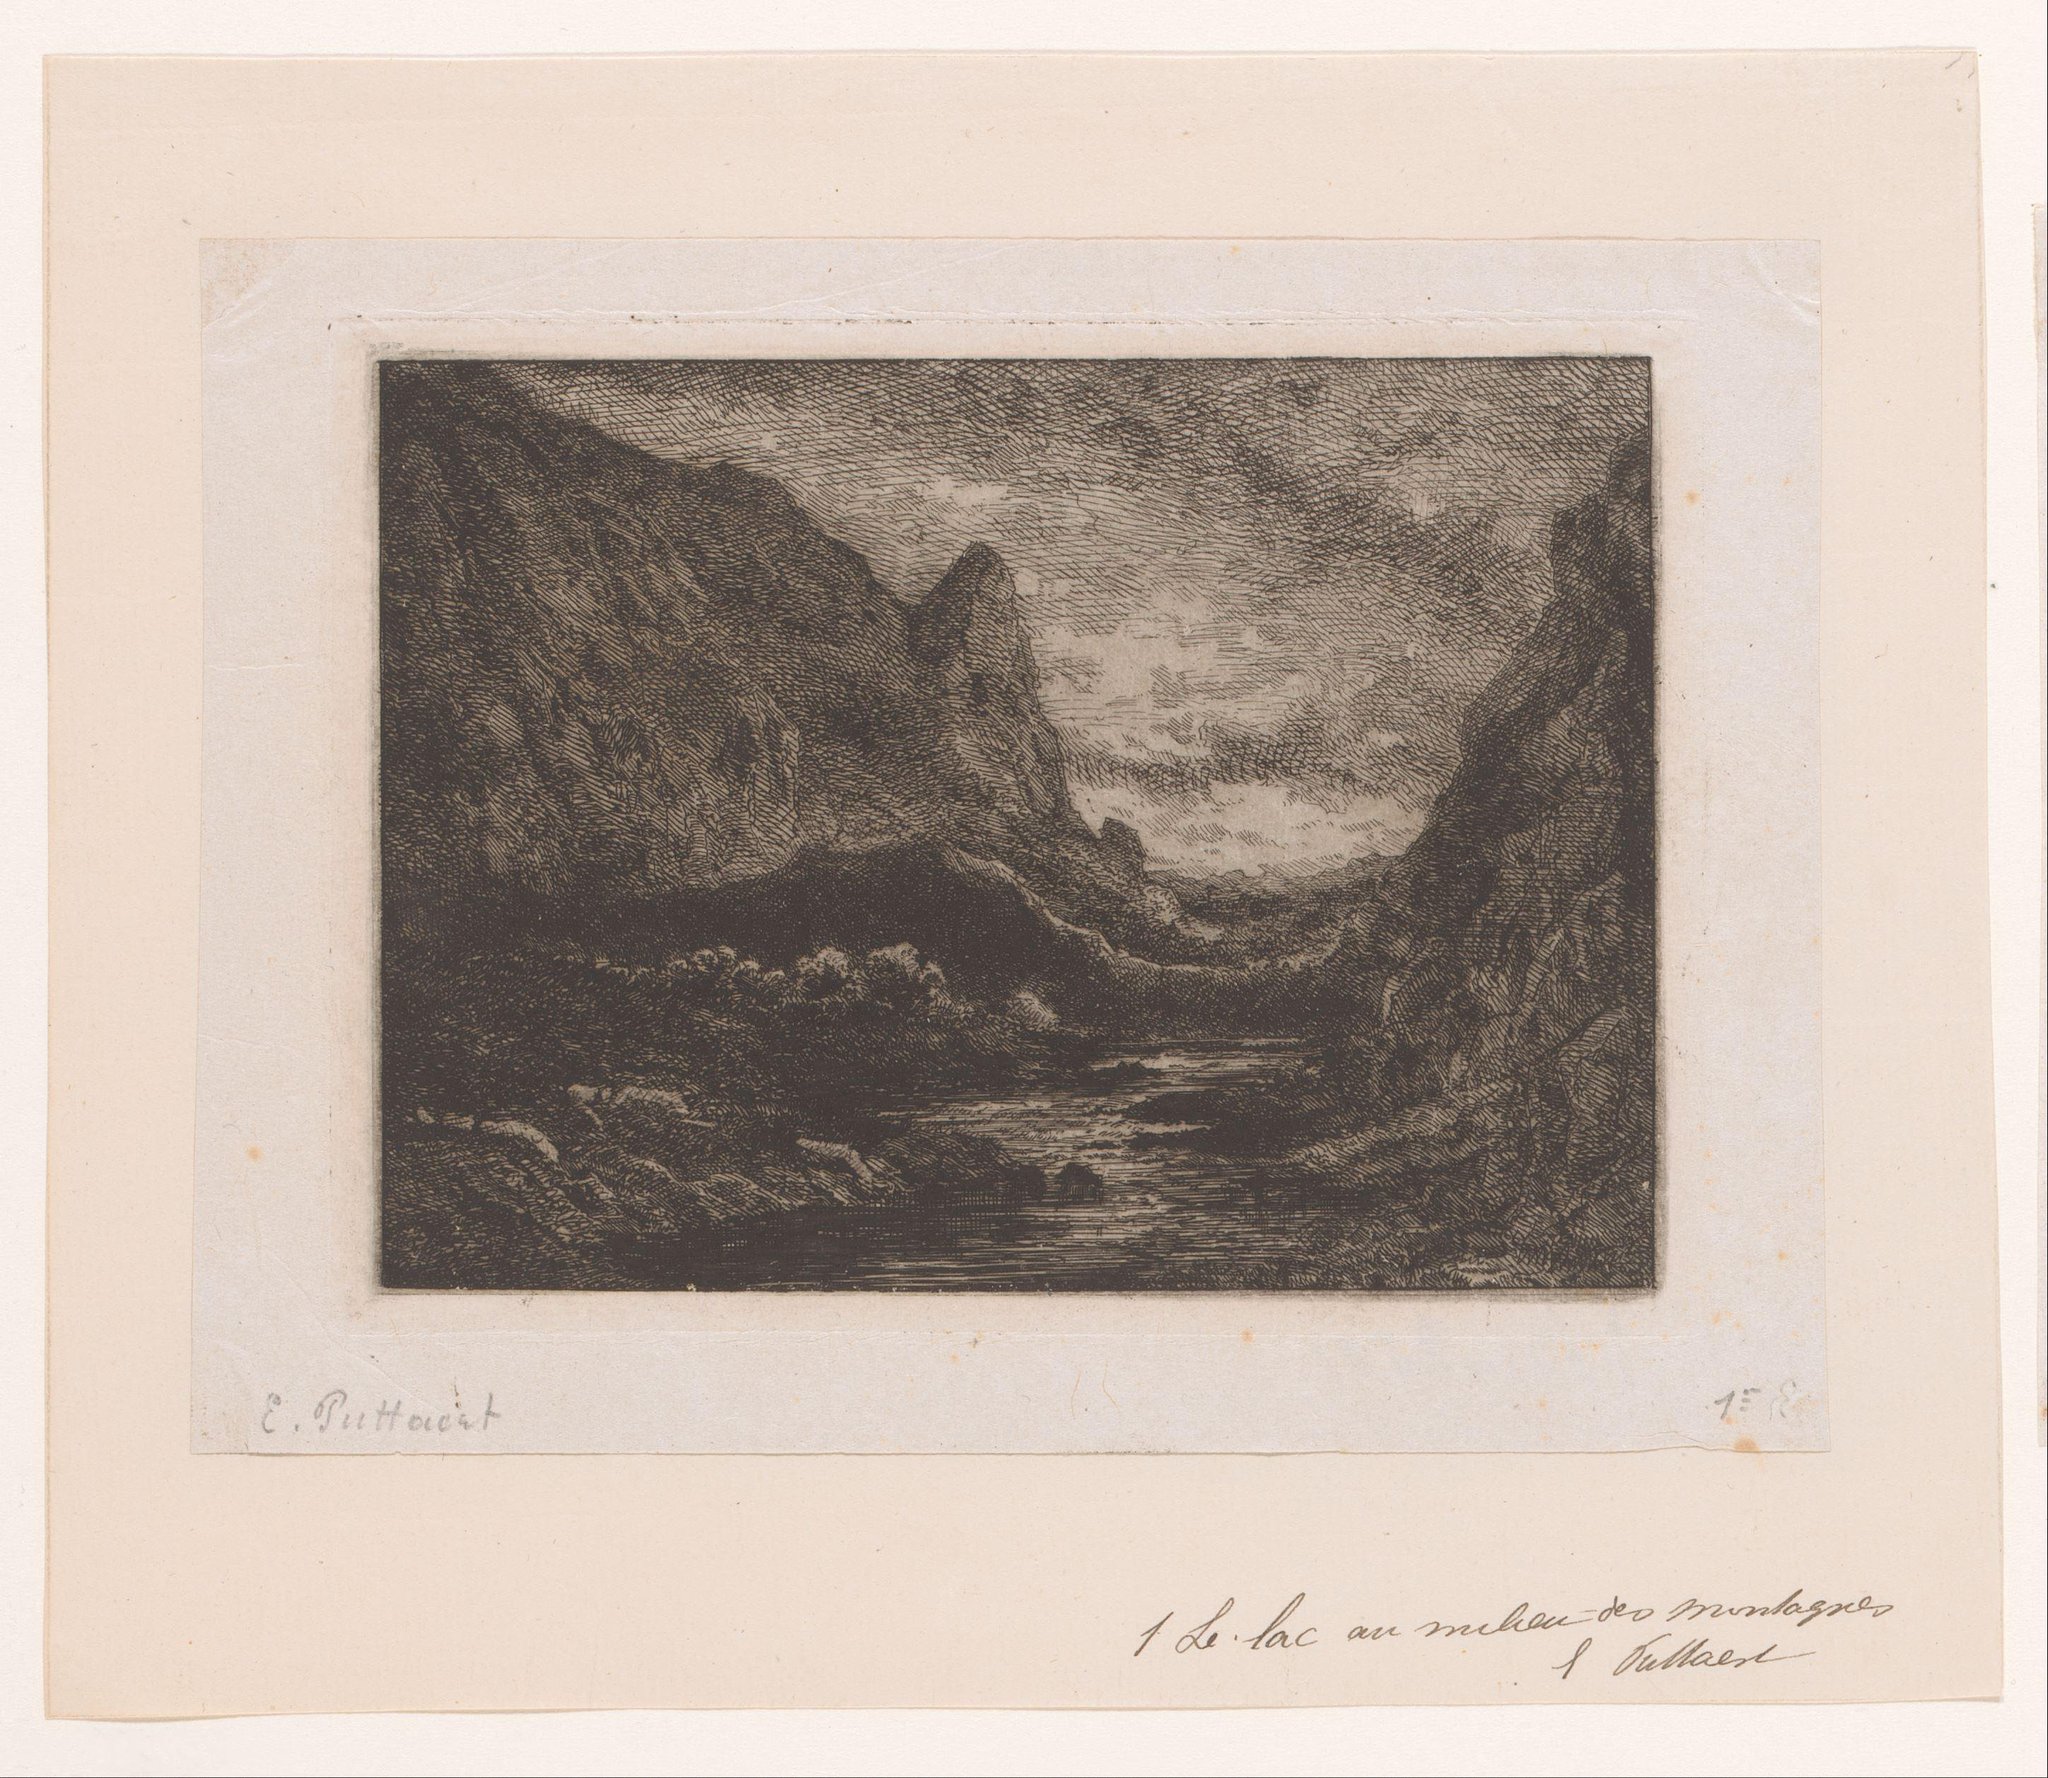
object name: print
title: Bergmeer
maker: emile puttaert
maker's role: print maker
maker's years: 1829-1901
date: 1839-1879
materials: paper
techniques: drypoint, etching, intaglio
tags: lake, mountains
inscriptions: collector's mark: Lugt 2228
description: Mogelijk gaat het bij de prenten RP-P-1913-2501 t/m 2503 om eenzelfde plaat (verschillende staten). Echter is voornamelijk de wolkenlucht steeds heel anders, waardoor er twijfel is over het gebruik van eenzelfde plaat. Het is daarom ook niet duidelijk welke prent precies wordt bedoeld in Hippert&Linnig.